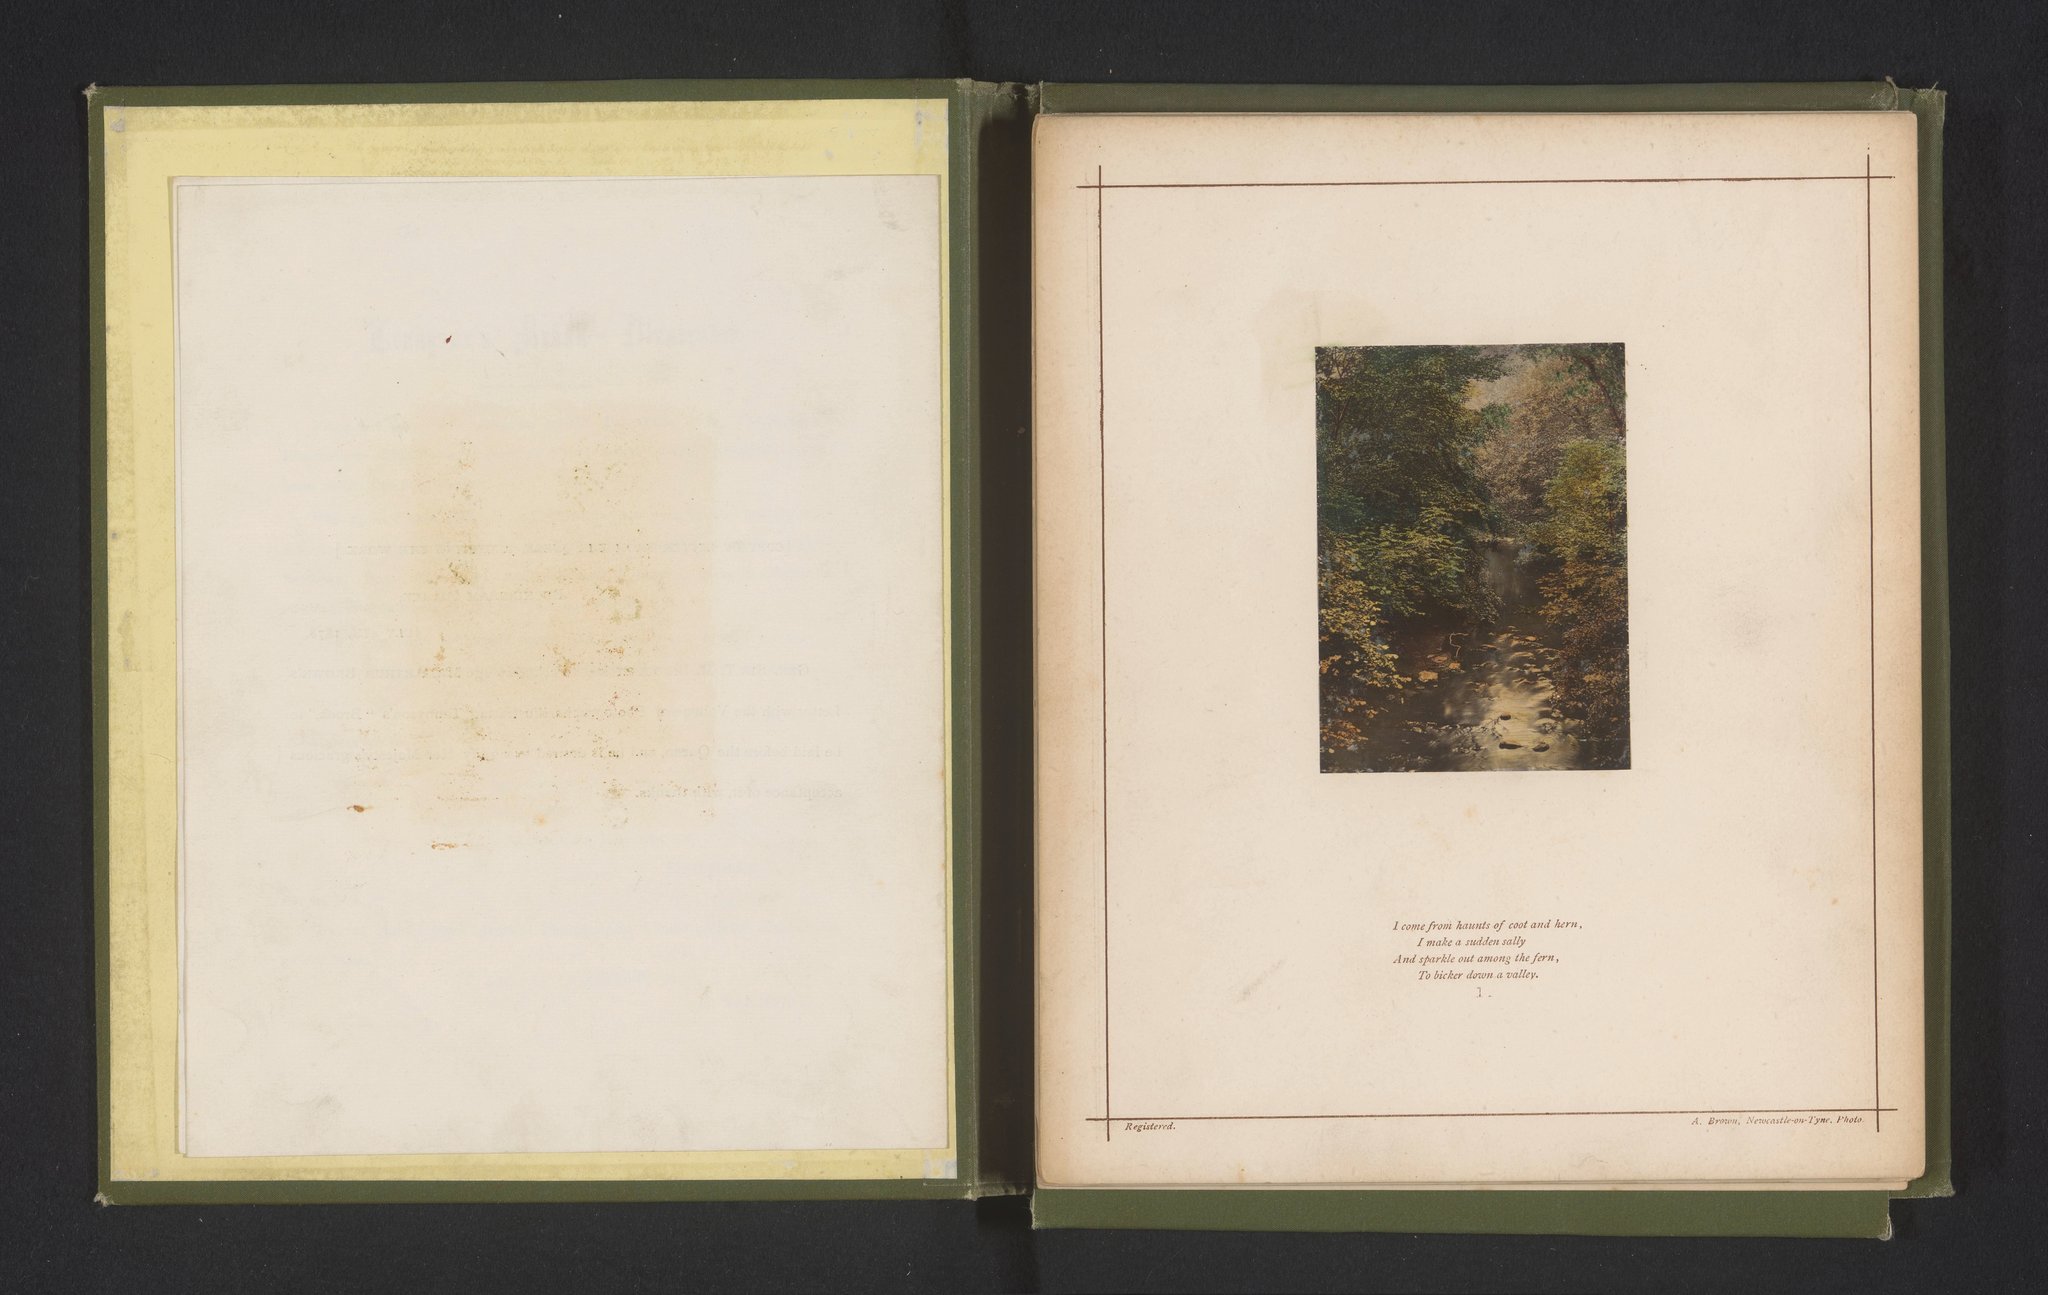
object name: photograph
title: Gezicht op de beek Skelton Beck nabij Saltburn-by-the-Sea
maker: arthur brown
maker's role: fotograaf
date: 1874-1879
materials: paper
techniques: carbon print, hand coloring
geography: north yorkshire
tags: brook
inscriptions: number: ‘1.’, inscription: ‘I come from haunts (...) down a valley.’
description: Deze foto maakt deel uit van een omslag met dertien foto's.